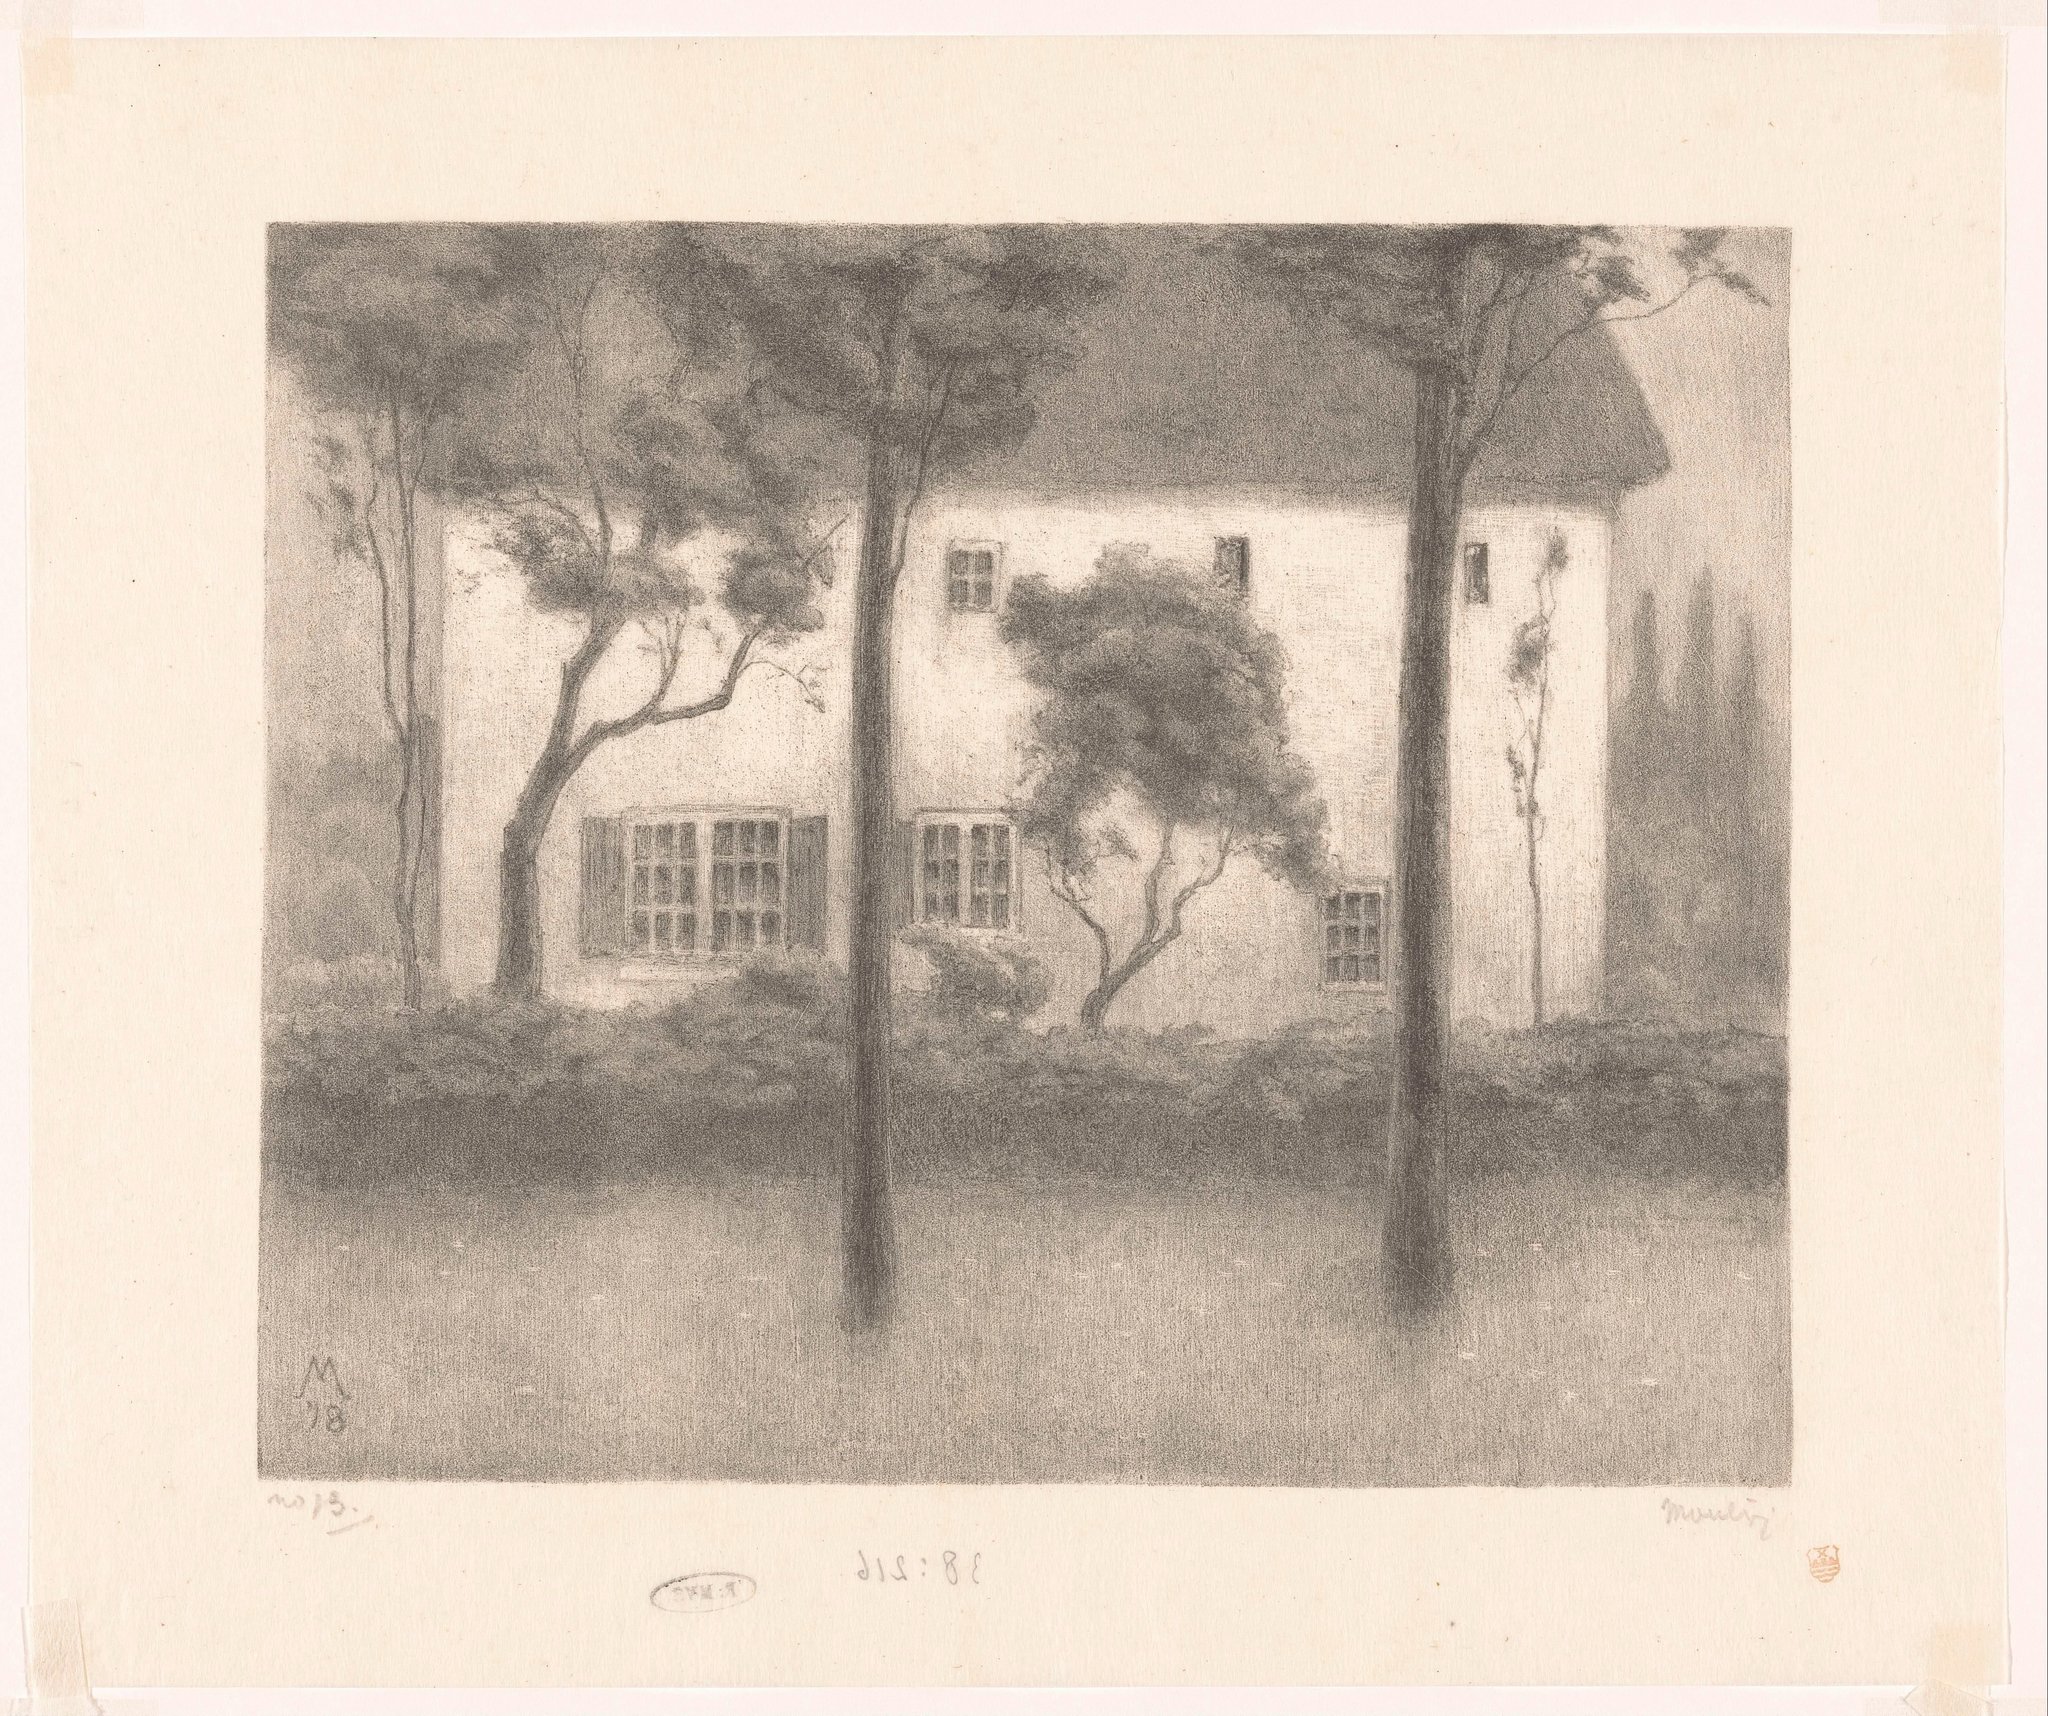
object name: print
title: Huis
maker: simon moulijn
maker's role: draughtsman, print maker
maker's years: 1866-1948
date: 1918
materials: paper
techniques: lithograph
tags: garden, rural housing, e.g. country-house, villa, cottage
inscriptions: number: ‘no 13.’, collector's mark: Lugt 2228, collector's mark: Lugt 2760